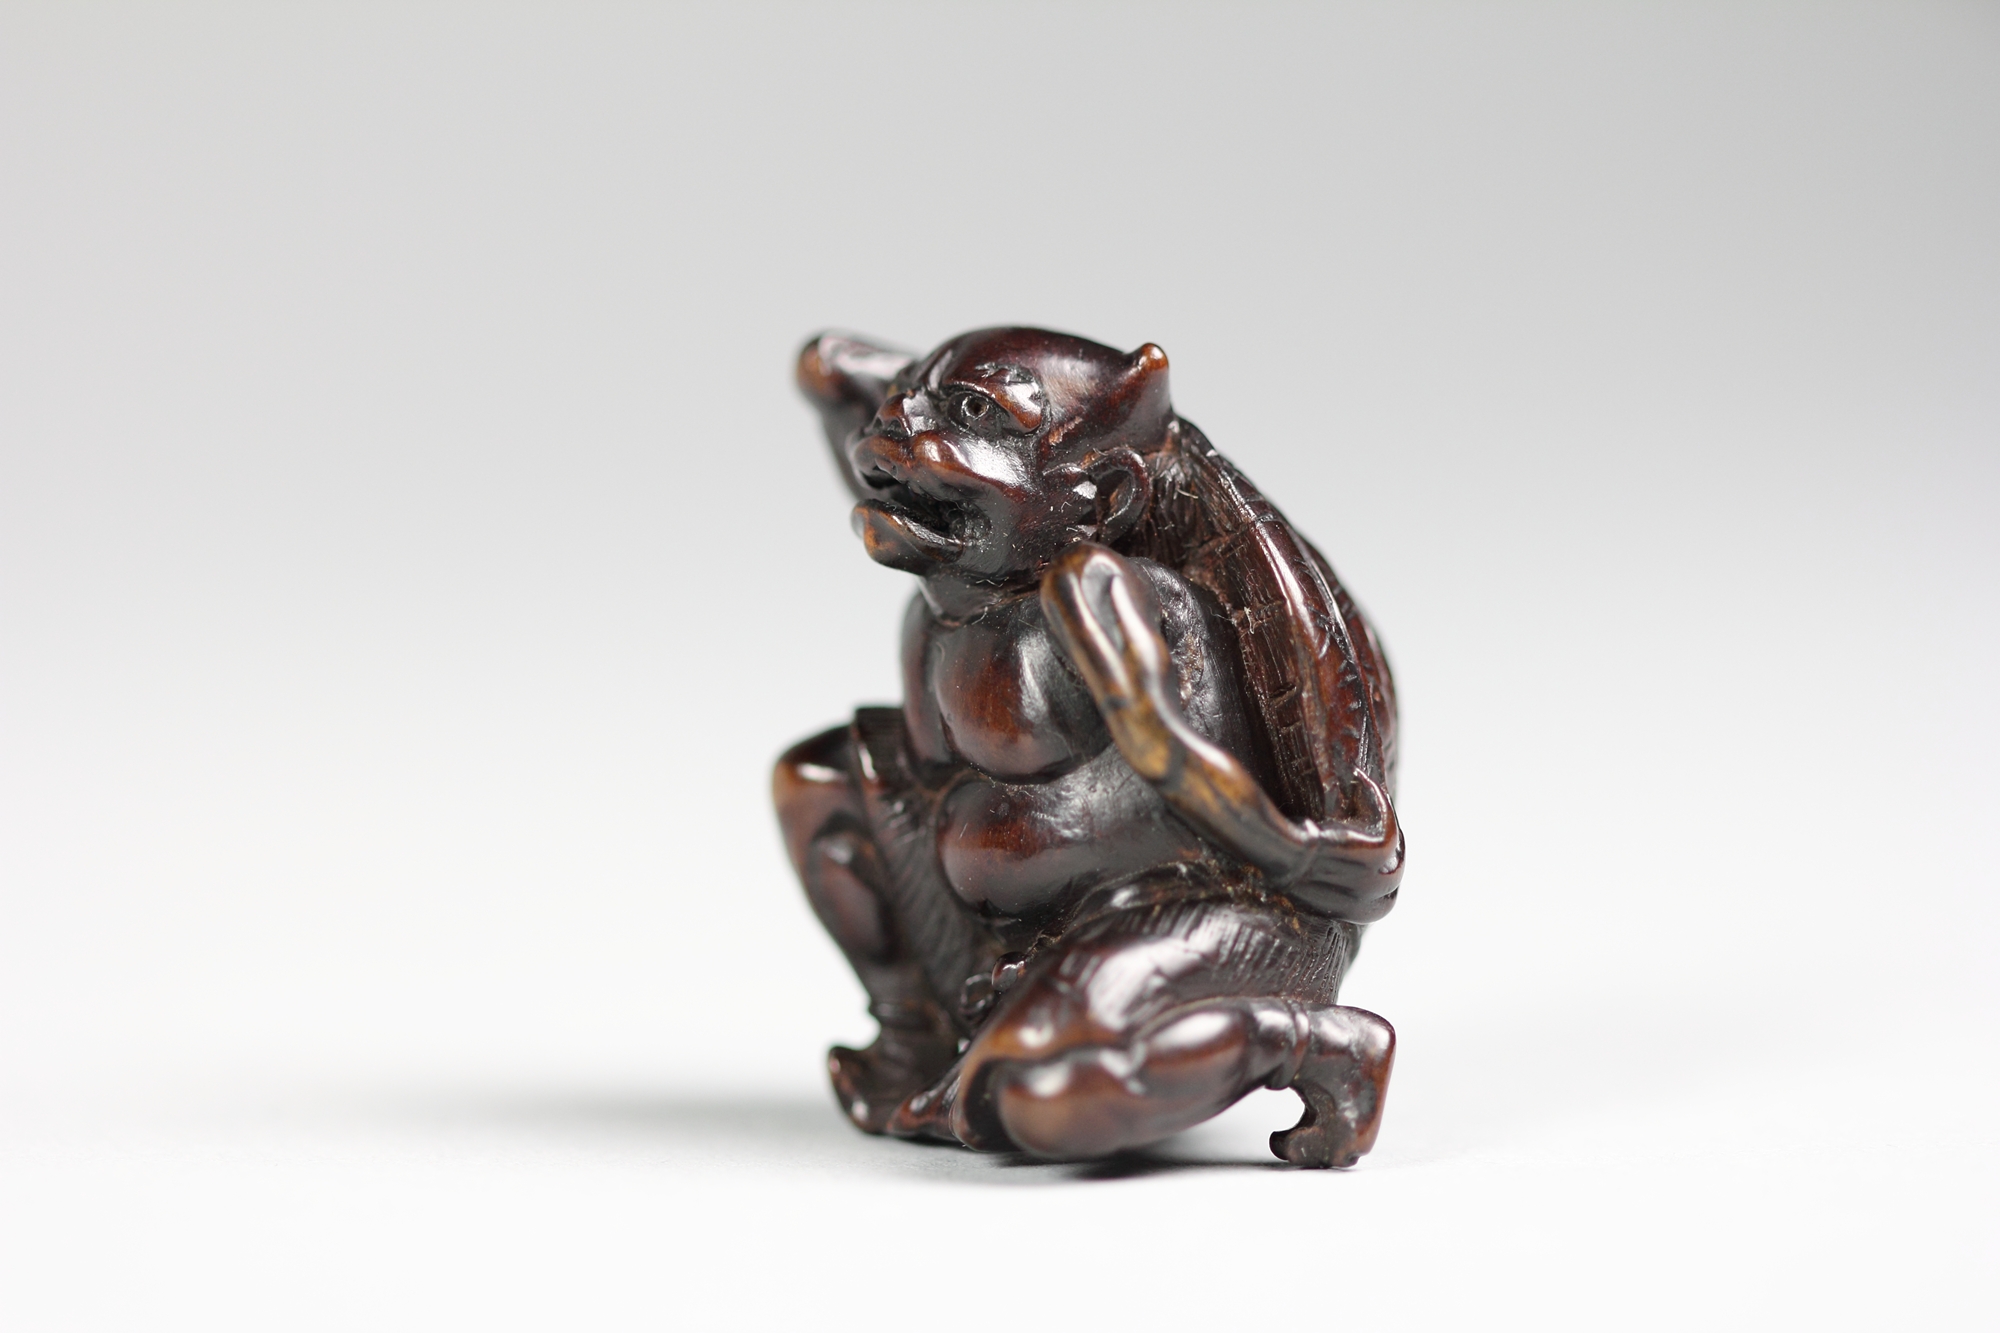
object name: netsuke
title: Netsuke of Demon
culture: japanese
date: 1801-1900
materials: wood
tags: demons